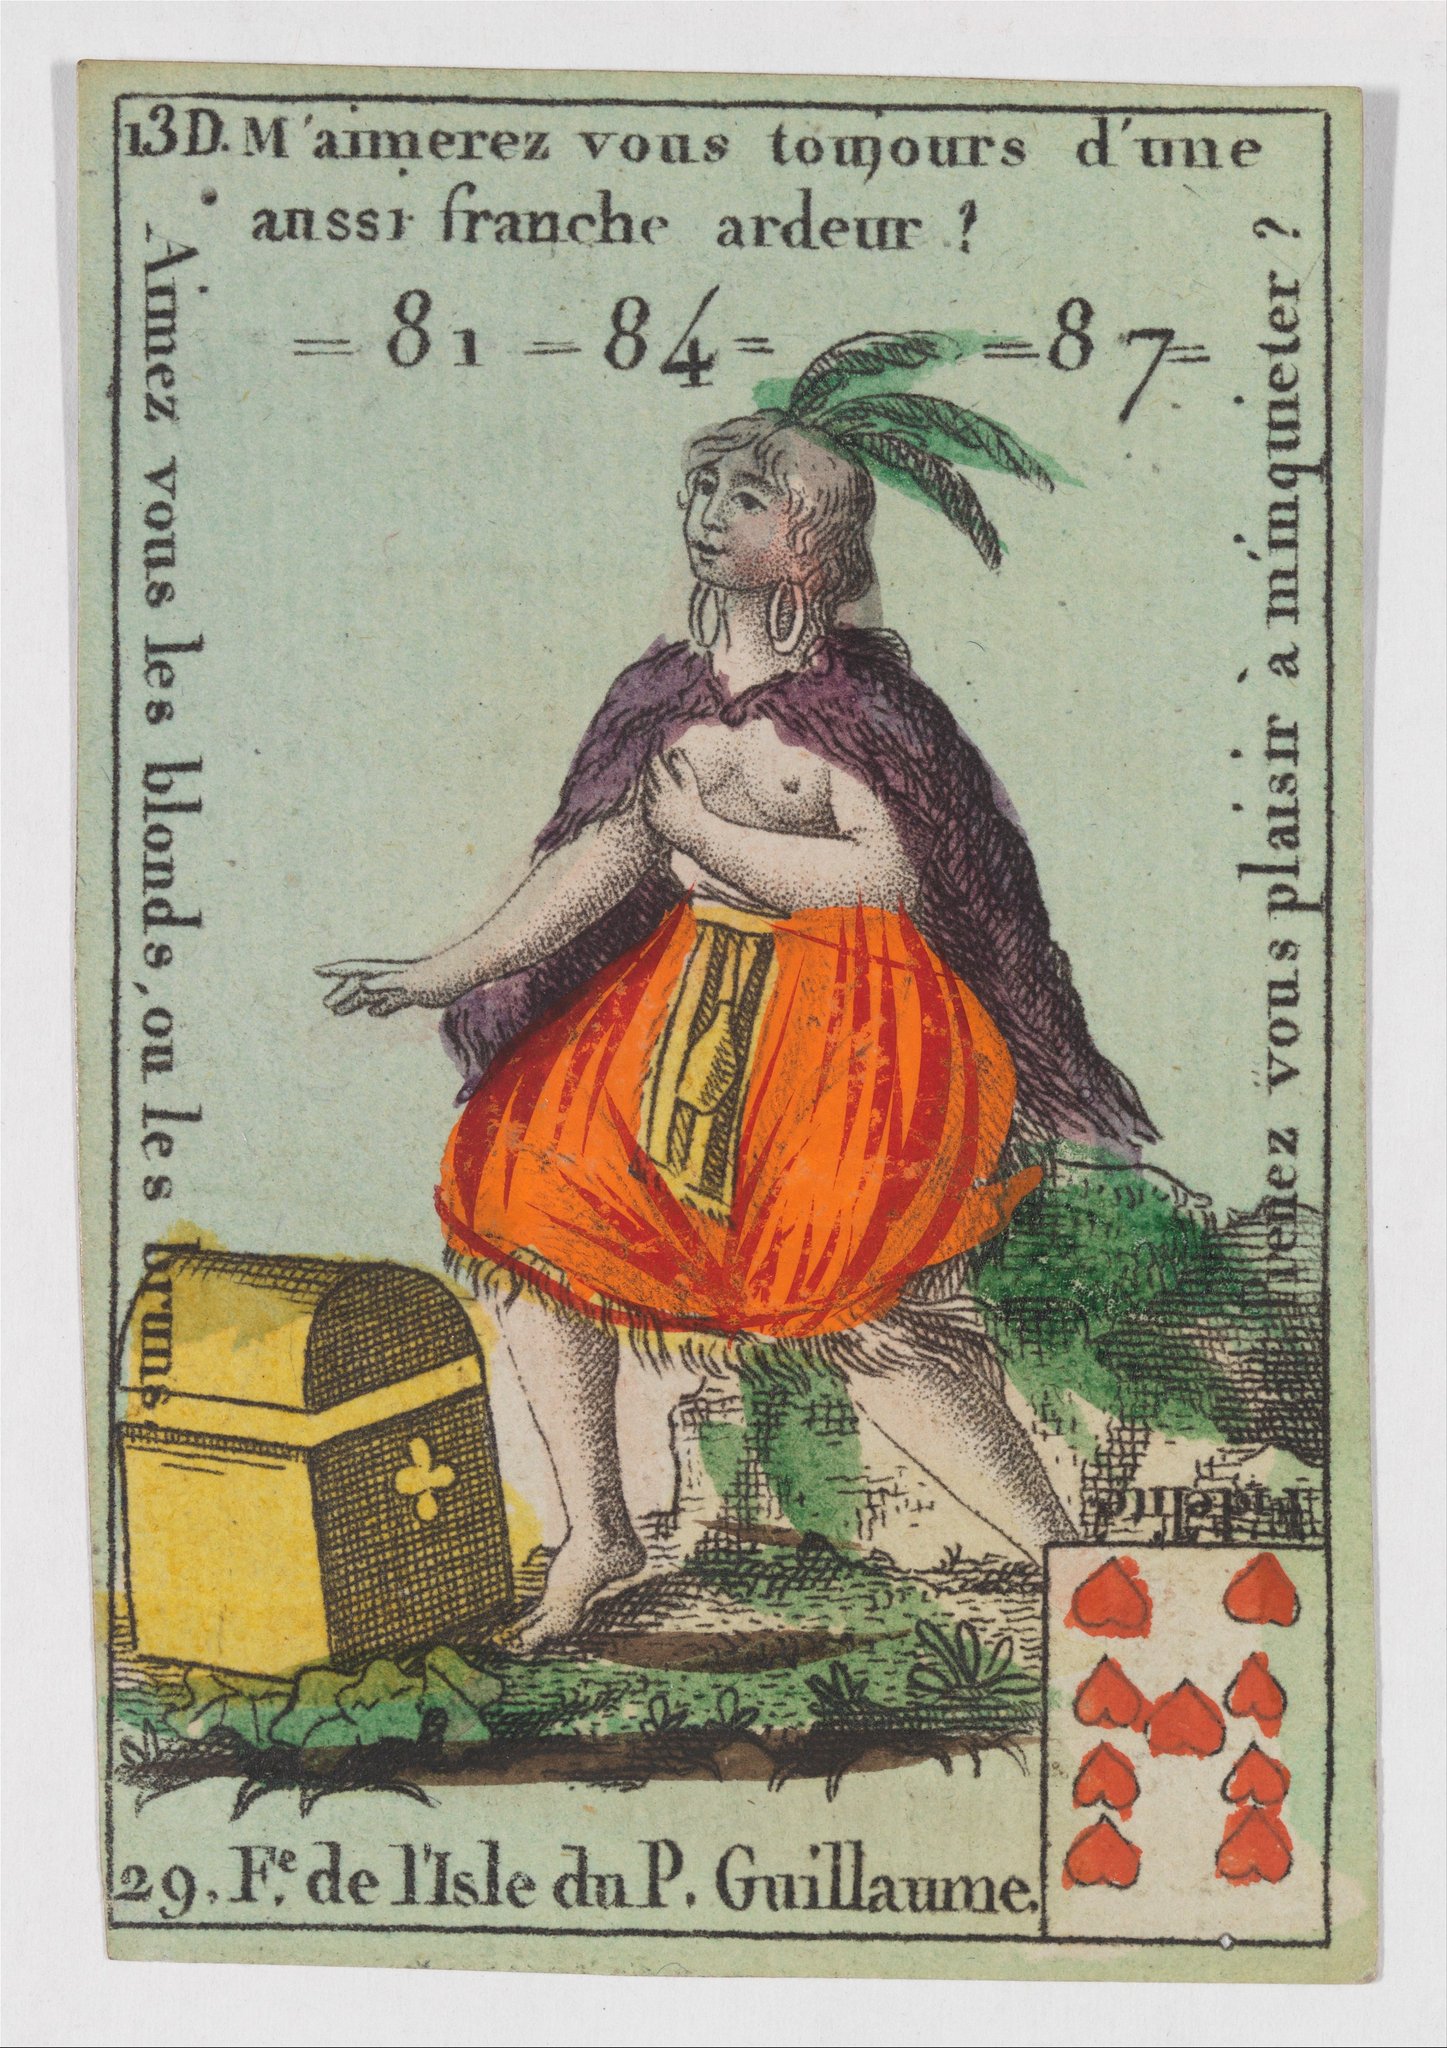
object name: print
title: F.e de l'Isle du P. Guillaume, from the playing cards (for quartets) "Costumes des Peuples Étrangers"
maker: anonymous, french, 18th century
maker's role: artist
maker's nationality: french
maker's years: 1700-1800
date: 1700-1799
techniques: etching, hand coloring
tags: portraits,female nudes,playing cards